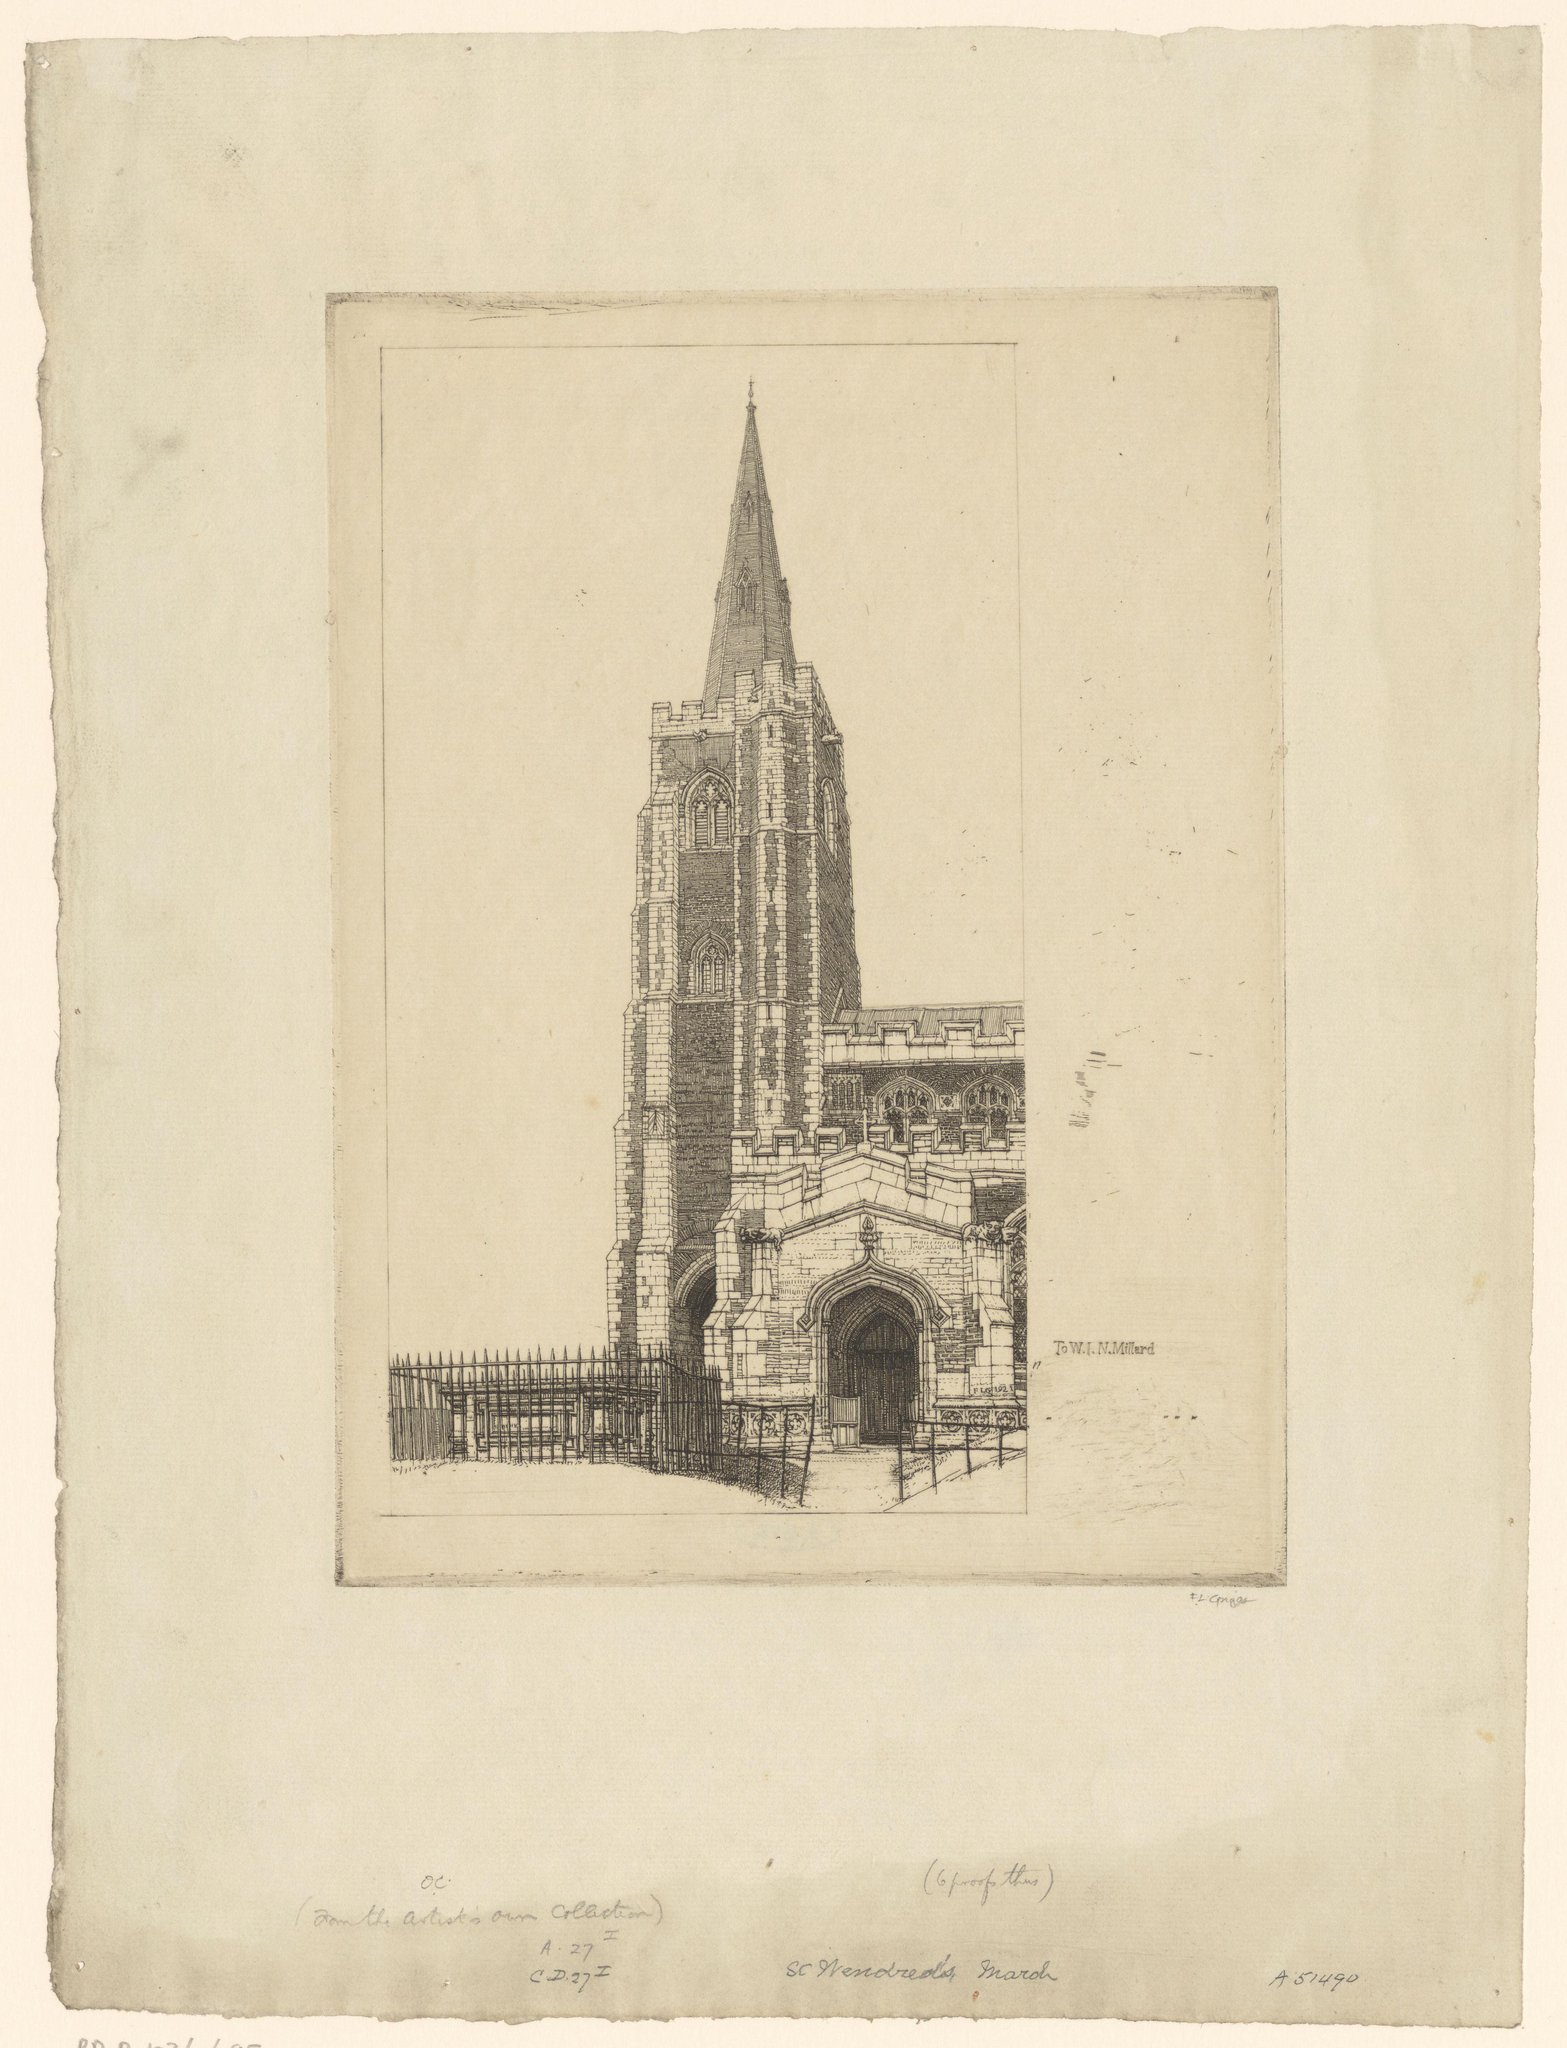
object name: print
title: Gezicht op de Sint Wendredakerk te March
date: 1921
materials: paper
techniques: etching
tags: church (exterior)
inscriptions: collector's mark: Lugt 2228, signature: ‘F.L. Griggs’